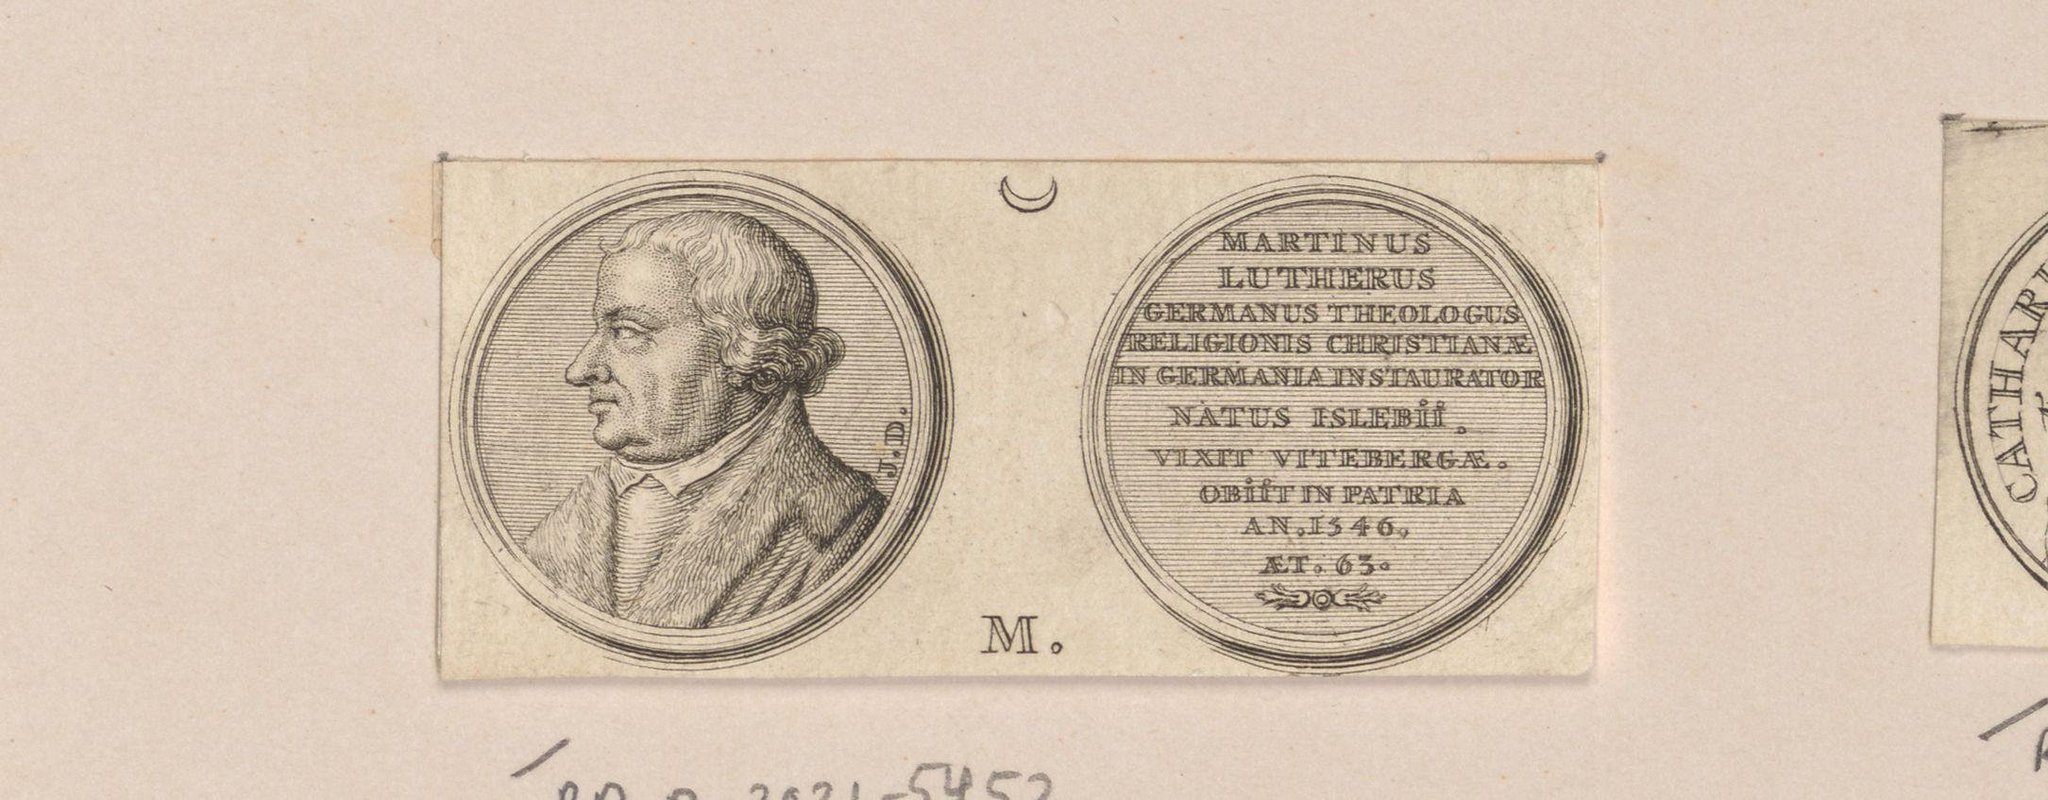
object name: print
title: Voor- en achterzijde van een penning met het portret van Martin Luther en Latijnse tekst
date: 1735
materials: paper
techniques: engraving, etching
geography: northern netherlands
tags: priest, martin luther, historical persons, medal (considered as a piece of sculpture, regardless of its specific function)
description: Prent met tekst in boekdruk op verso gebruikt in: Mieris, Frans van. Histori der Nederlandsche vorsten (...). Den Haag: Pieter de Hondt, 1735, dl. 3, p. 136. Met bovenin de prent het symbool voor zilver. De letter M. verwijst waarschijnlijk naar de eigenaar van de penning.